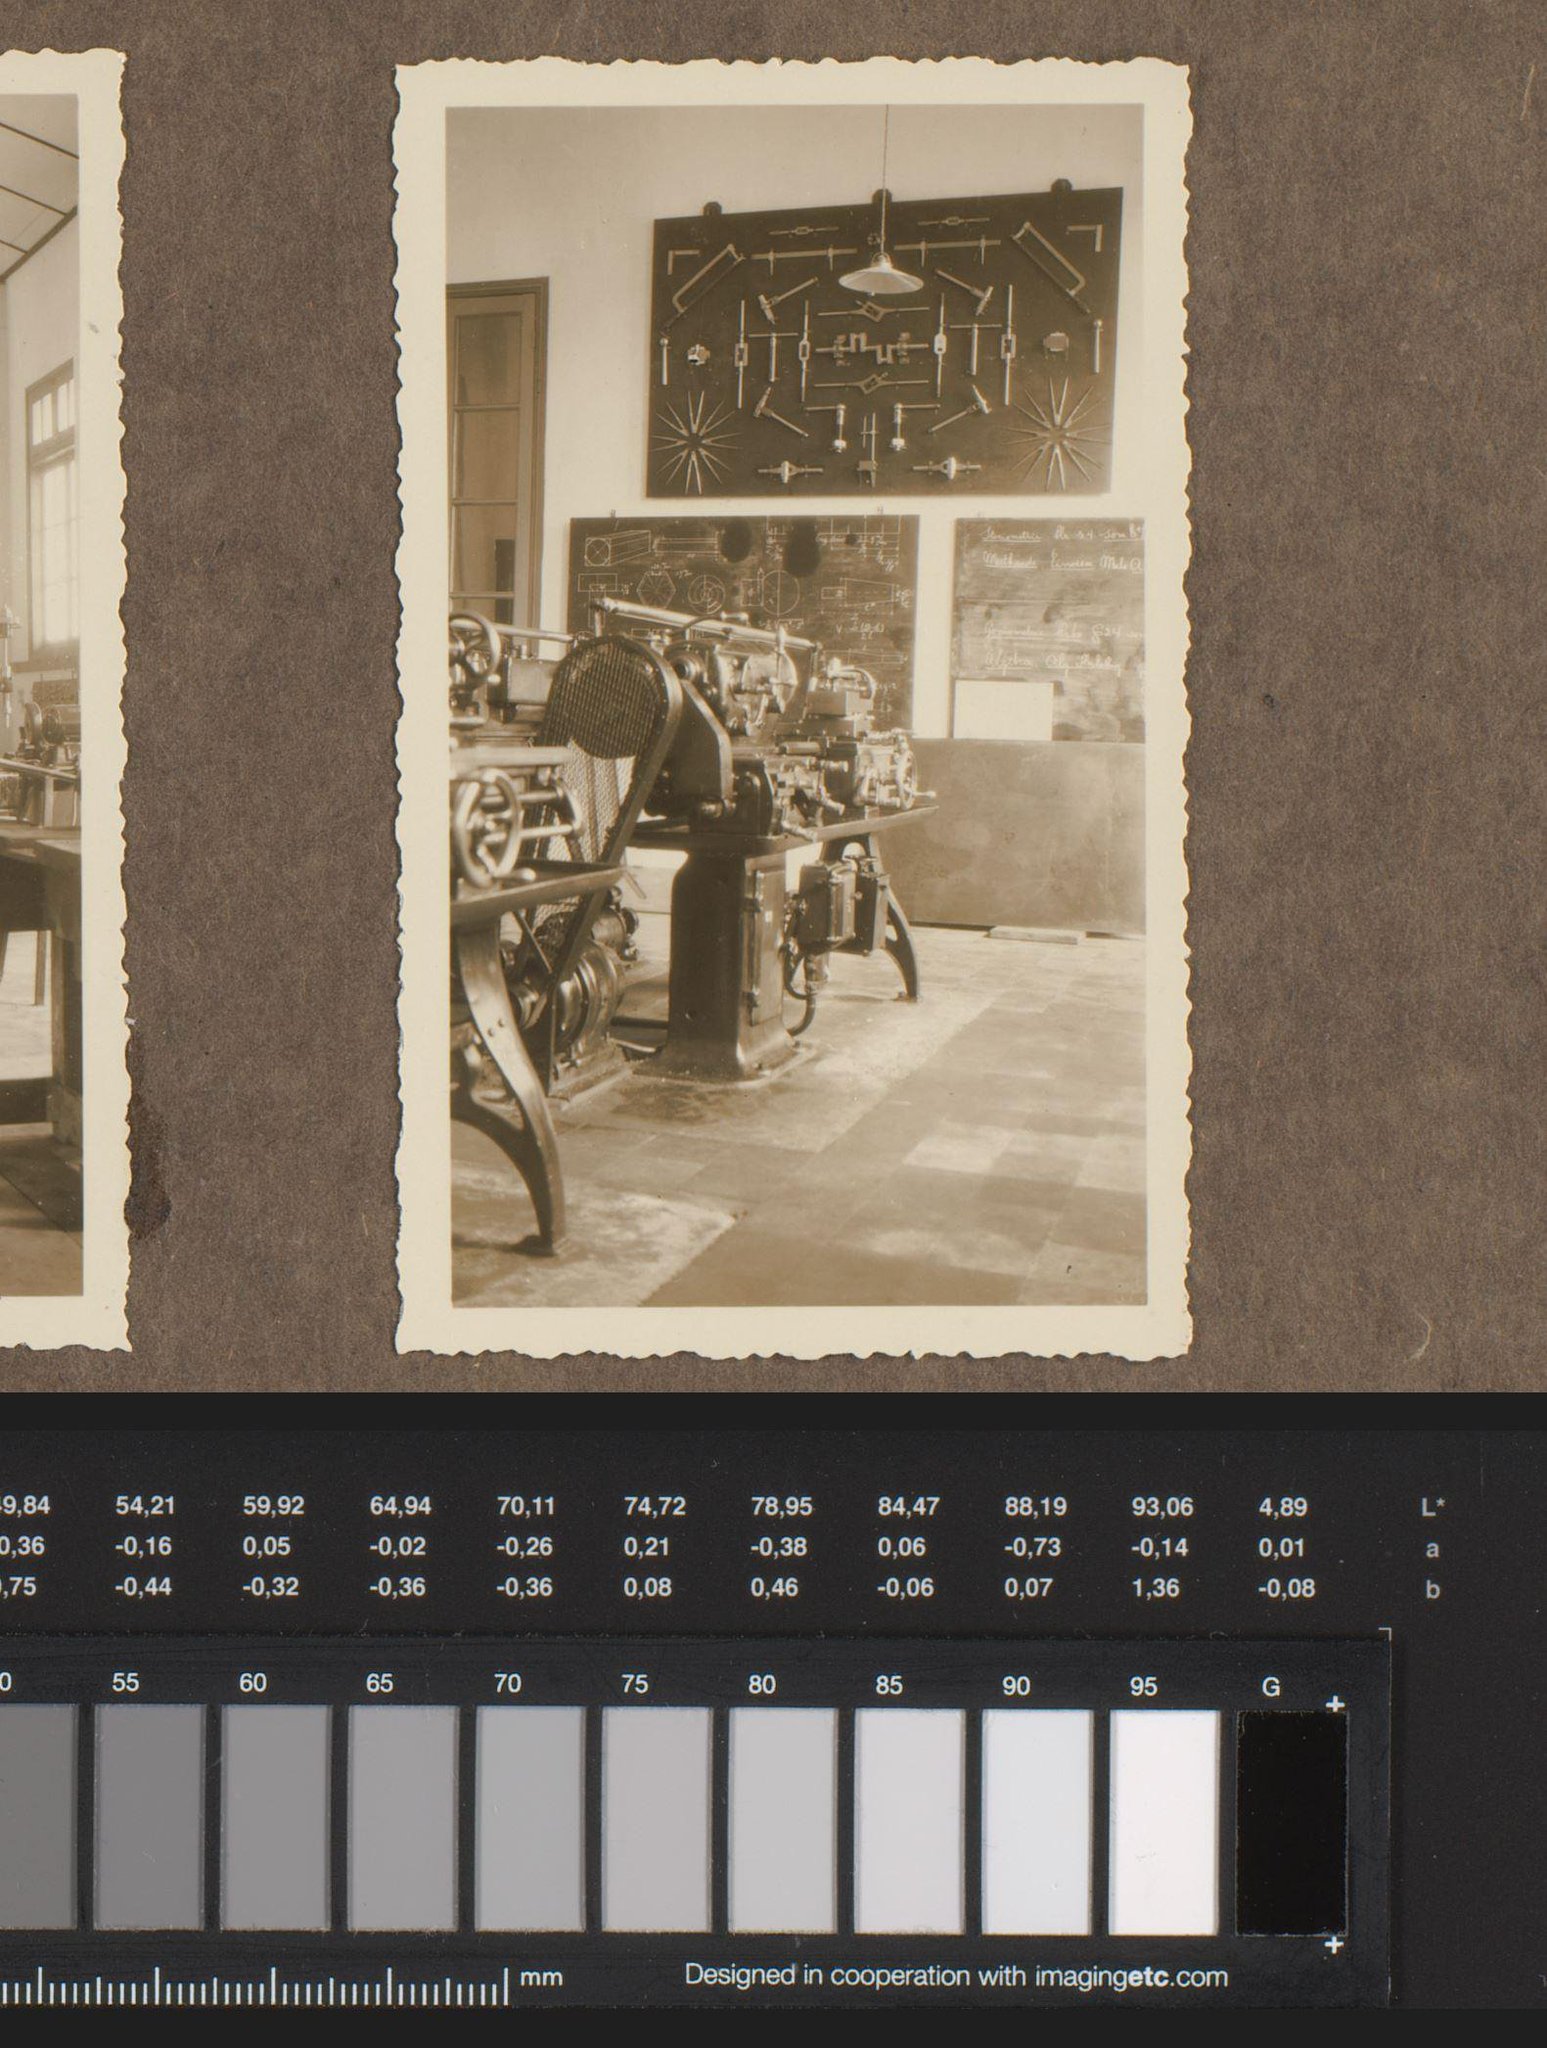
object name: photograph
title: Draaibanken van de Technische School te Bandoeng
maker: Anonymous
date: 1933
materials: photographic support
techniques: gelatin silver print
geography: bandung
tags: vocational education, e.g.: junior technical school, colonial government, dutch east indies, the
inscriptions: inscription: ‘Bankwerkeryen / TS’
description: Draaibanken in de werkplaats van de Technische School te Bandoeng. Foto ingeplakt in het fotoalbum aangeboden aan J.H.A. van der Hoeven bij het beëindigen op 31 juli 1933 van zijn diensttijd bij het Nijverheidsonderwijs in Nederlandsch-Indië.